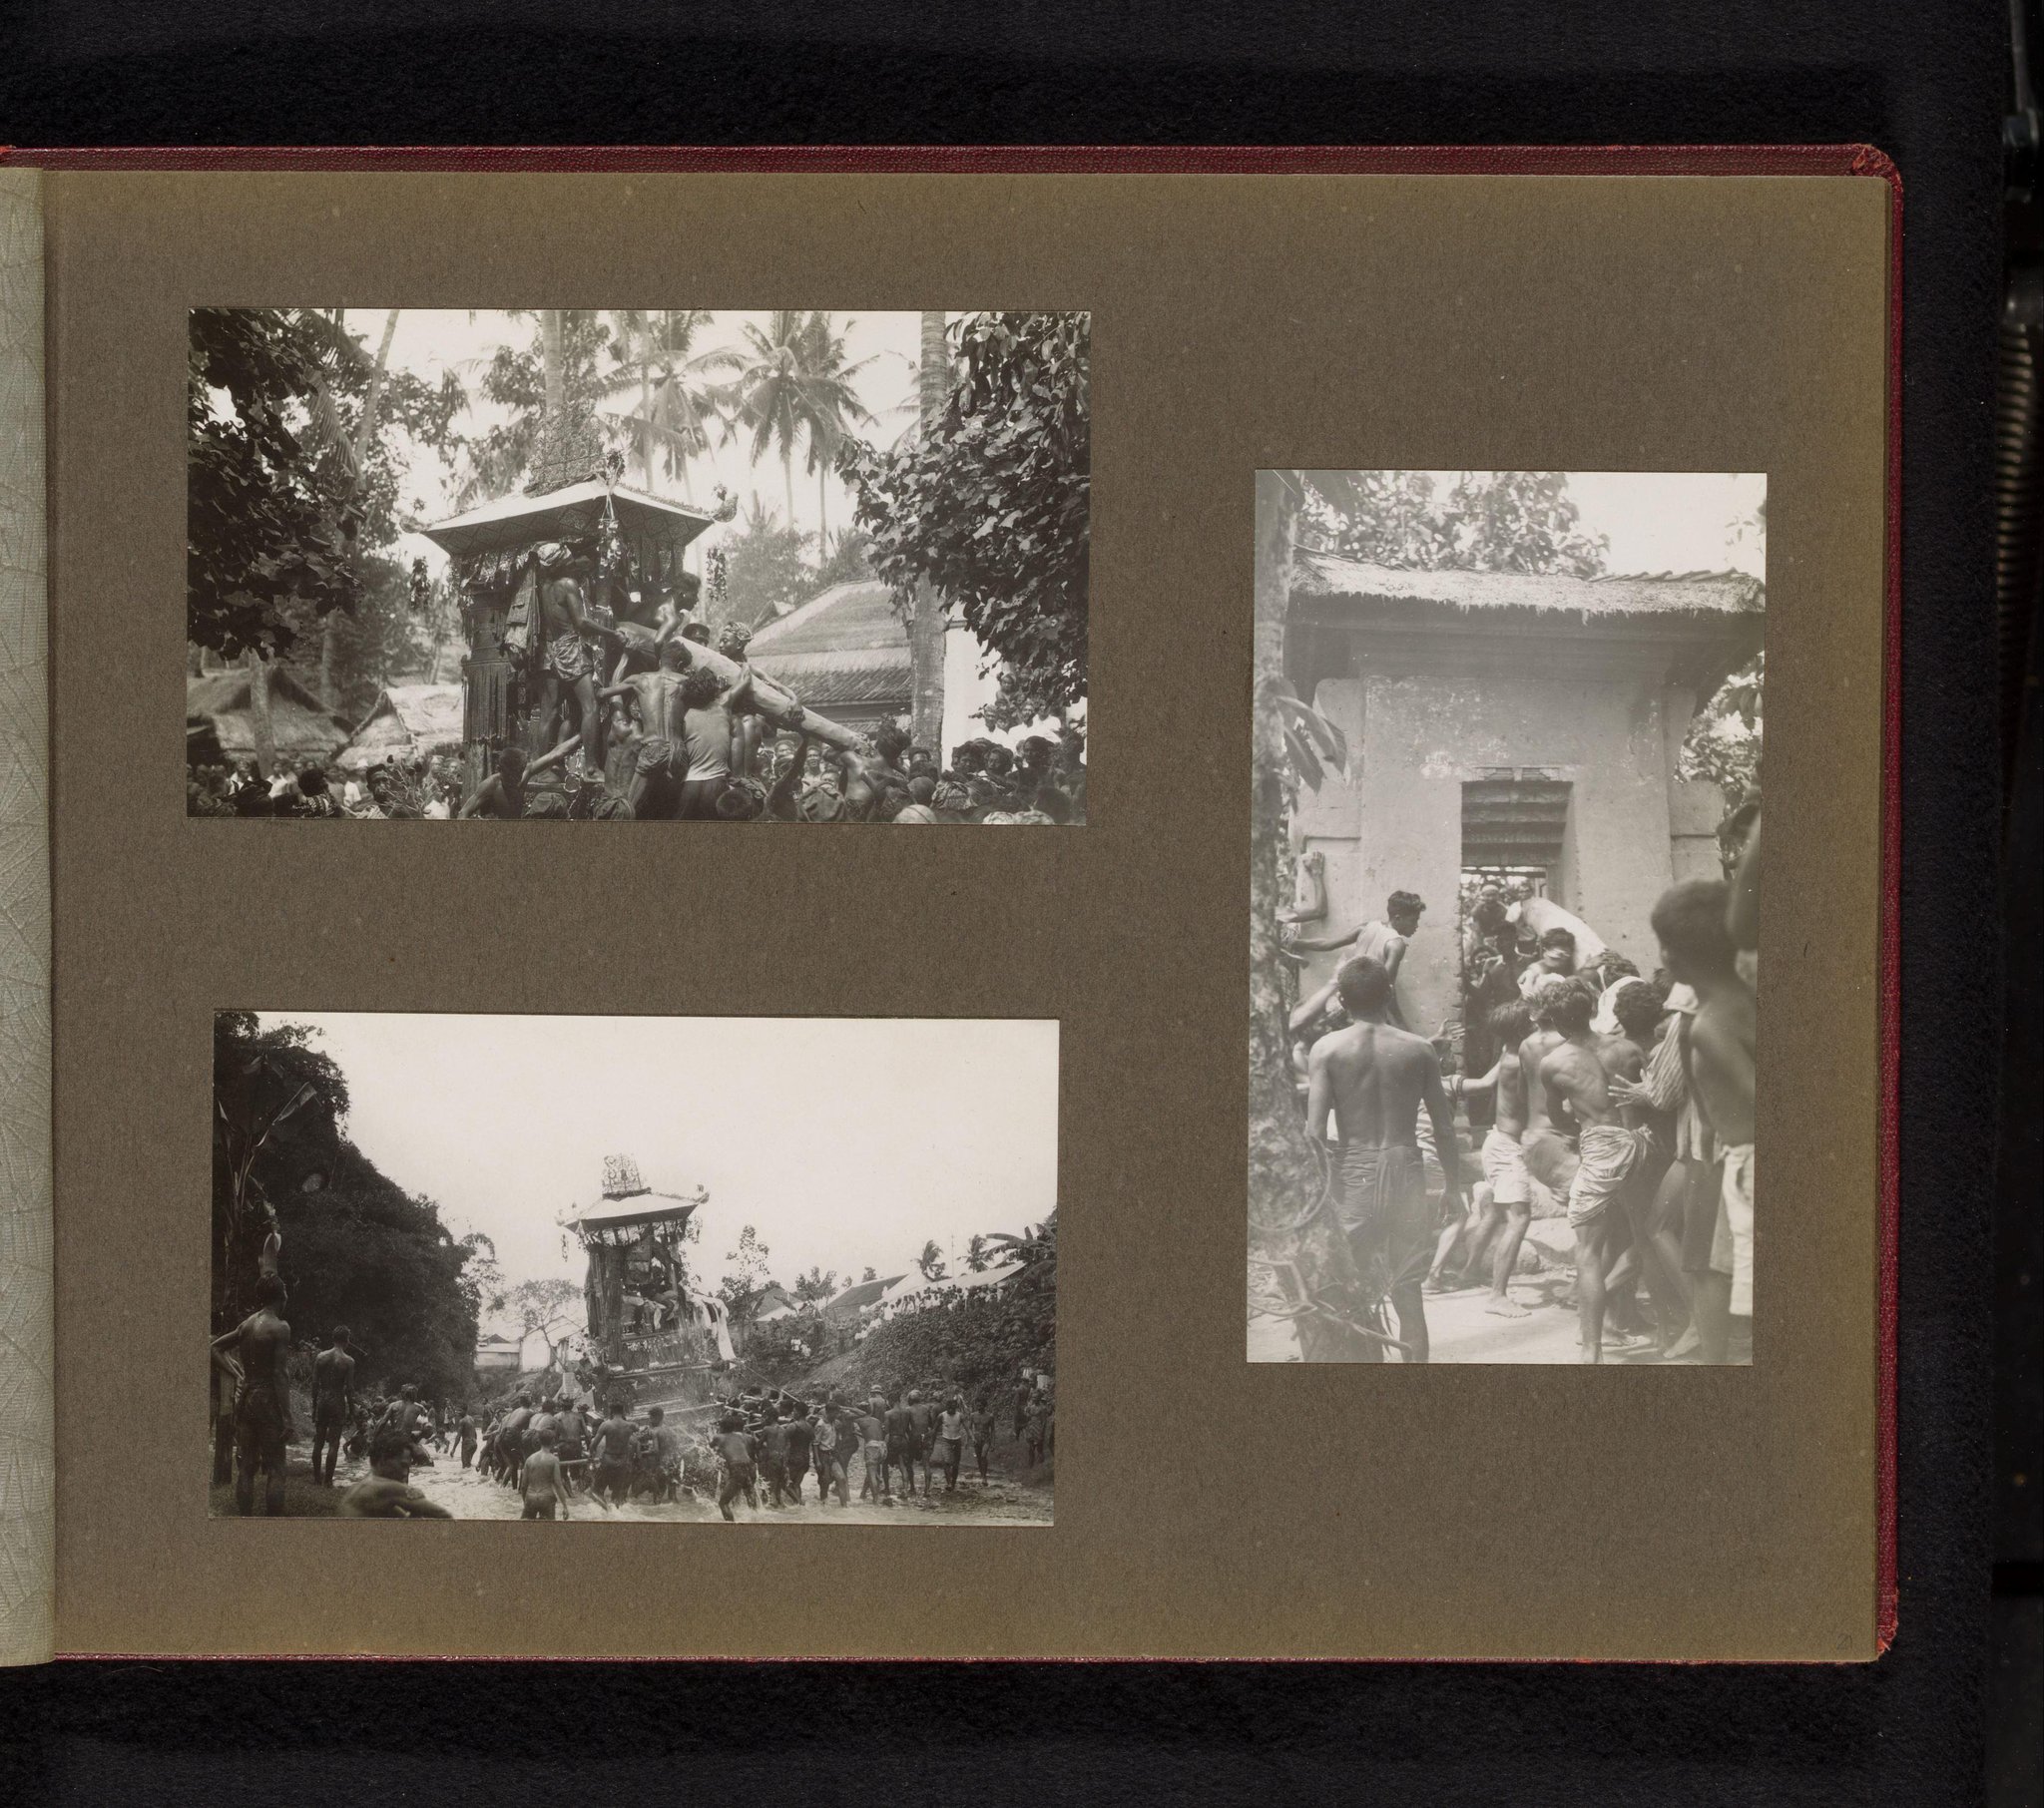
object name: photograph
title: Drie opnamen van rituele gebruiken, mogelijk rond een uitvaart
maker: Anonymous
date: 1950-1960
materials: photographic support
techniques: gelatin silver print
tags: ritual practices ~ non-christian religions, historical persons, dutch east indies, the